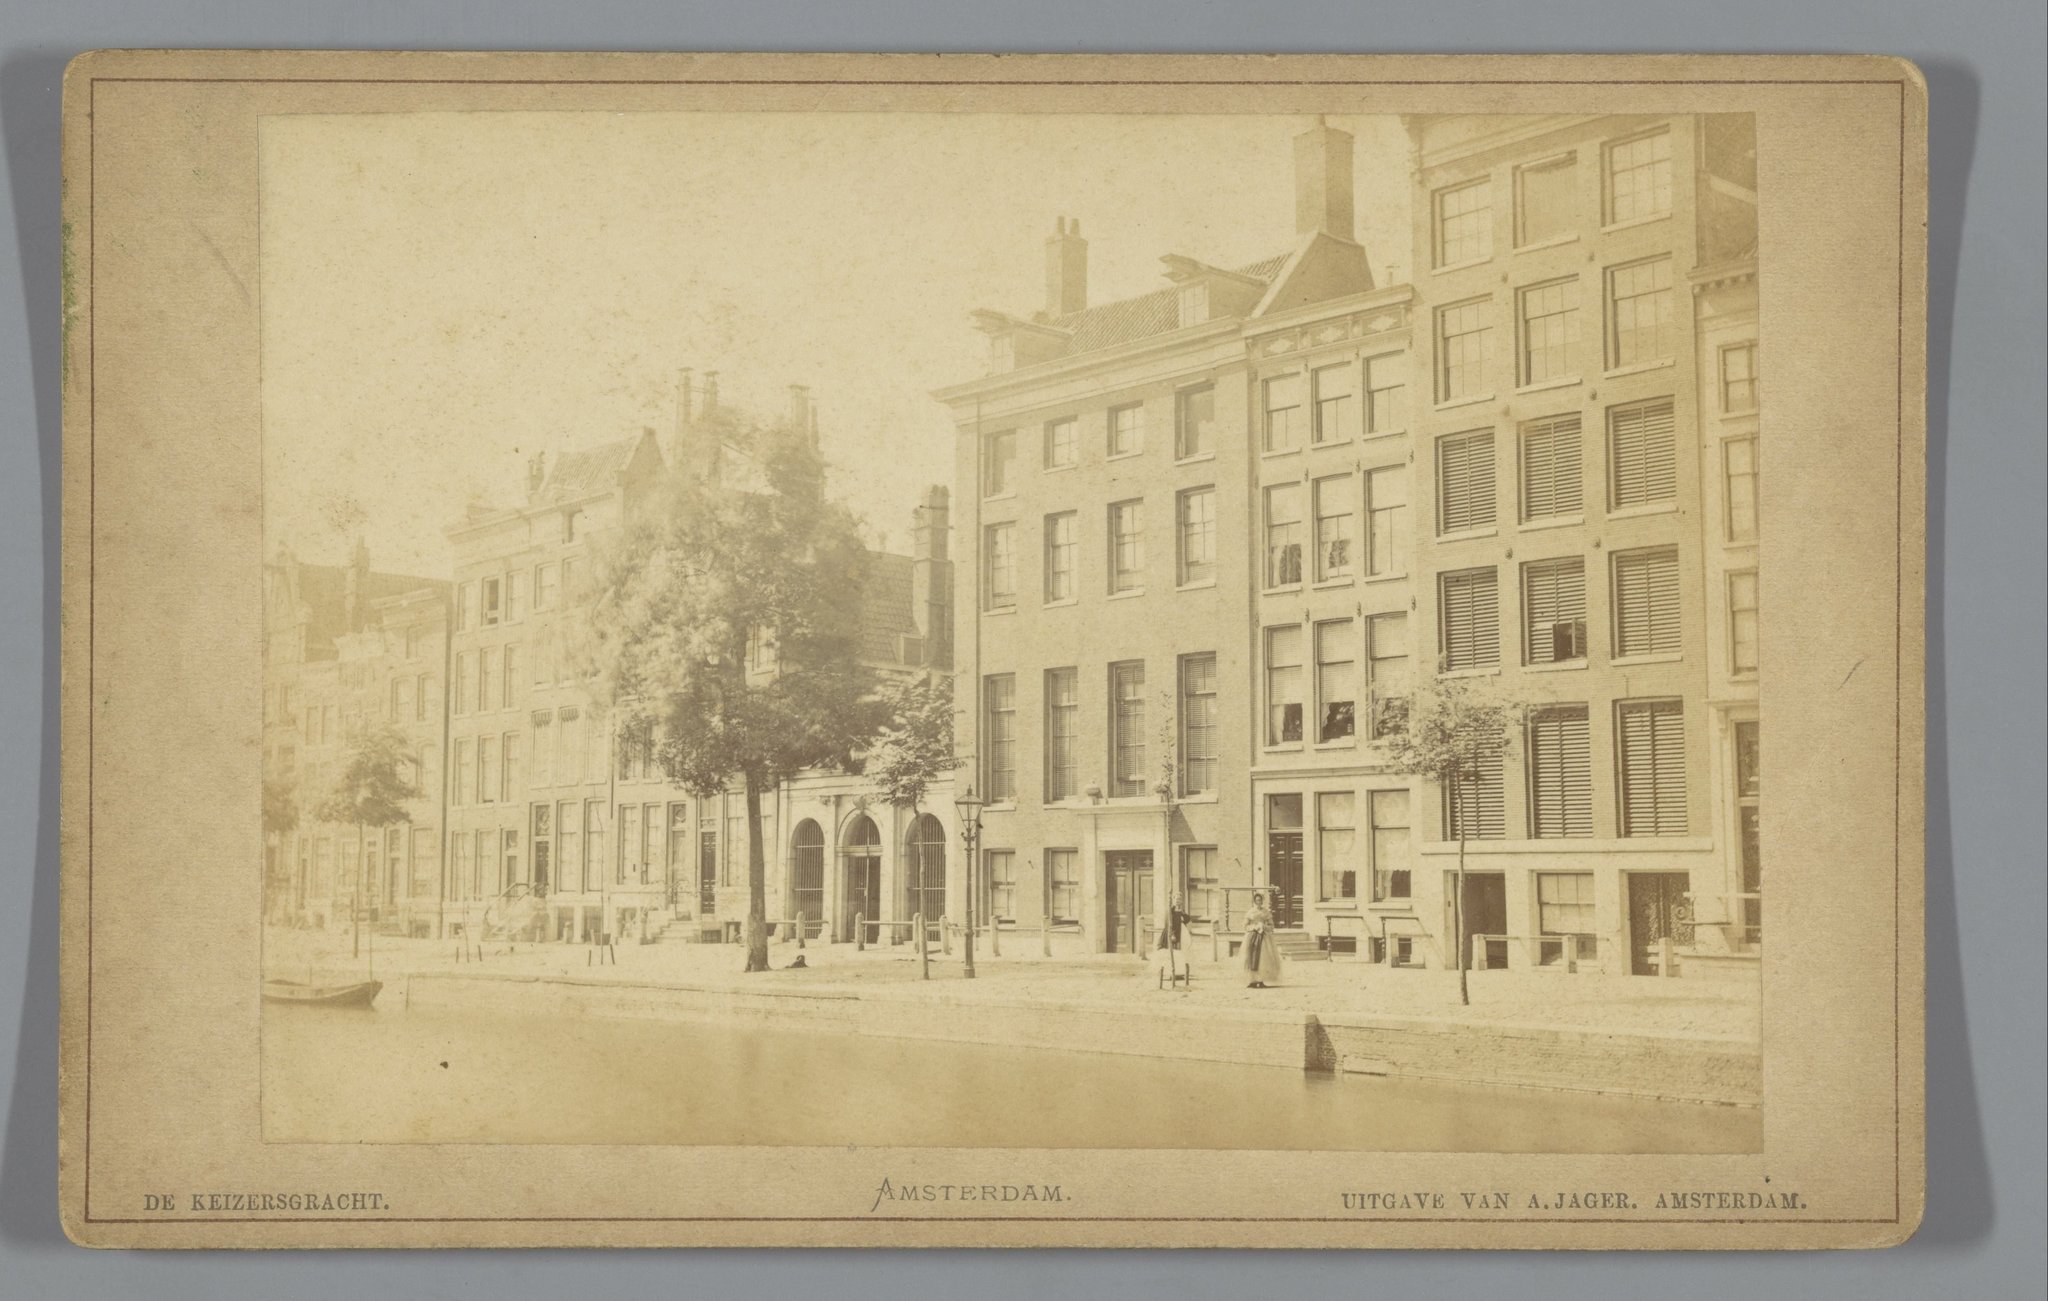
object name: cabinet photograph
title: Gezicht op een deel van de Keizersgracht in Amsterdam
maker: andries jager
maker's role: publisher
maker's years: 1825-1905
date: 1860-1890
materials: cardboard, photographic support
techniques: albumen print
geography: amsterdam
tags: canals, waters (in city), street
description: Tussen de huizen staat de Schouwburgpoort.